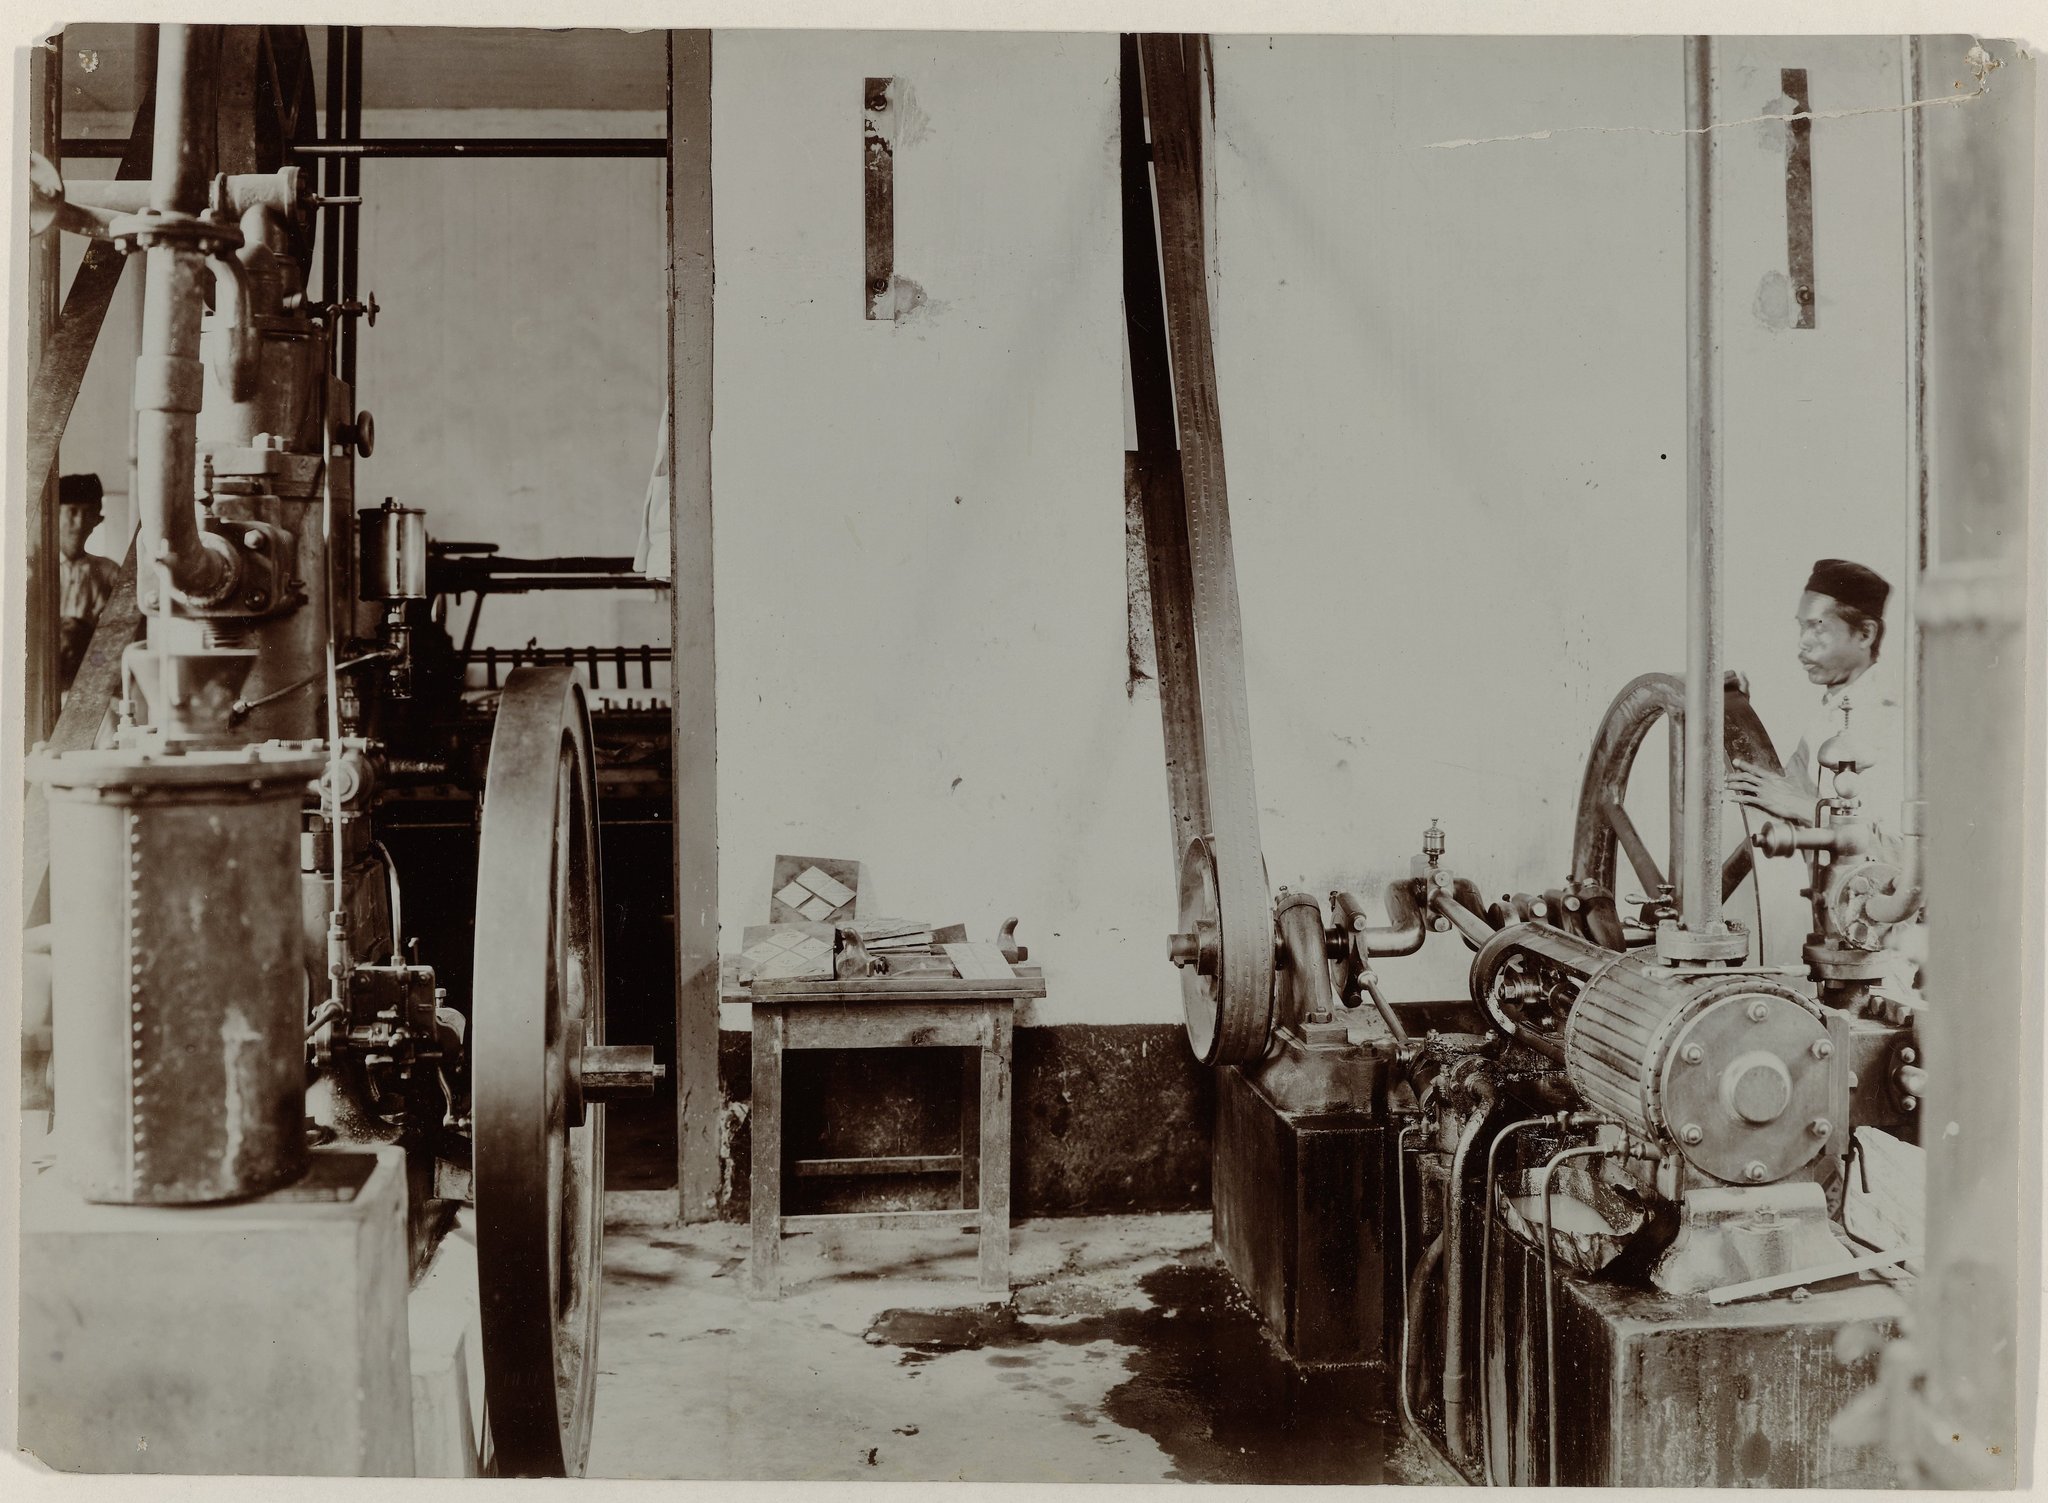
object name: photograph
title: Machinekamer van de drukkerij van de Deli Courant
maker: Anonymous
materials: photographic support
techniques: collodion silver print, gelatin silver print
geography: medan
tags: dutch east indies, the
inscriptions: inscription: ‘Machine kamer’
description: Gezicht in de machinekamer van de drukkerij van de Deli Courant te Medan. Achter een machine een Javaanse werknemer. Onderdeel van een aparte groep van negen foto's uit 1908 binnen de gehele groep van 49 losse zwart-wit foto's van verschillend formaat over de uitgeverij en drukkerij van de krant Deli Courant in Medan in de periode 1885-1947.